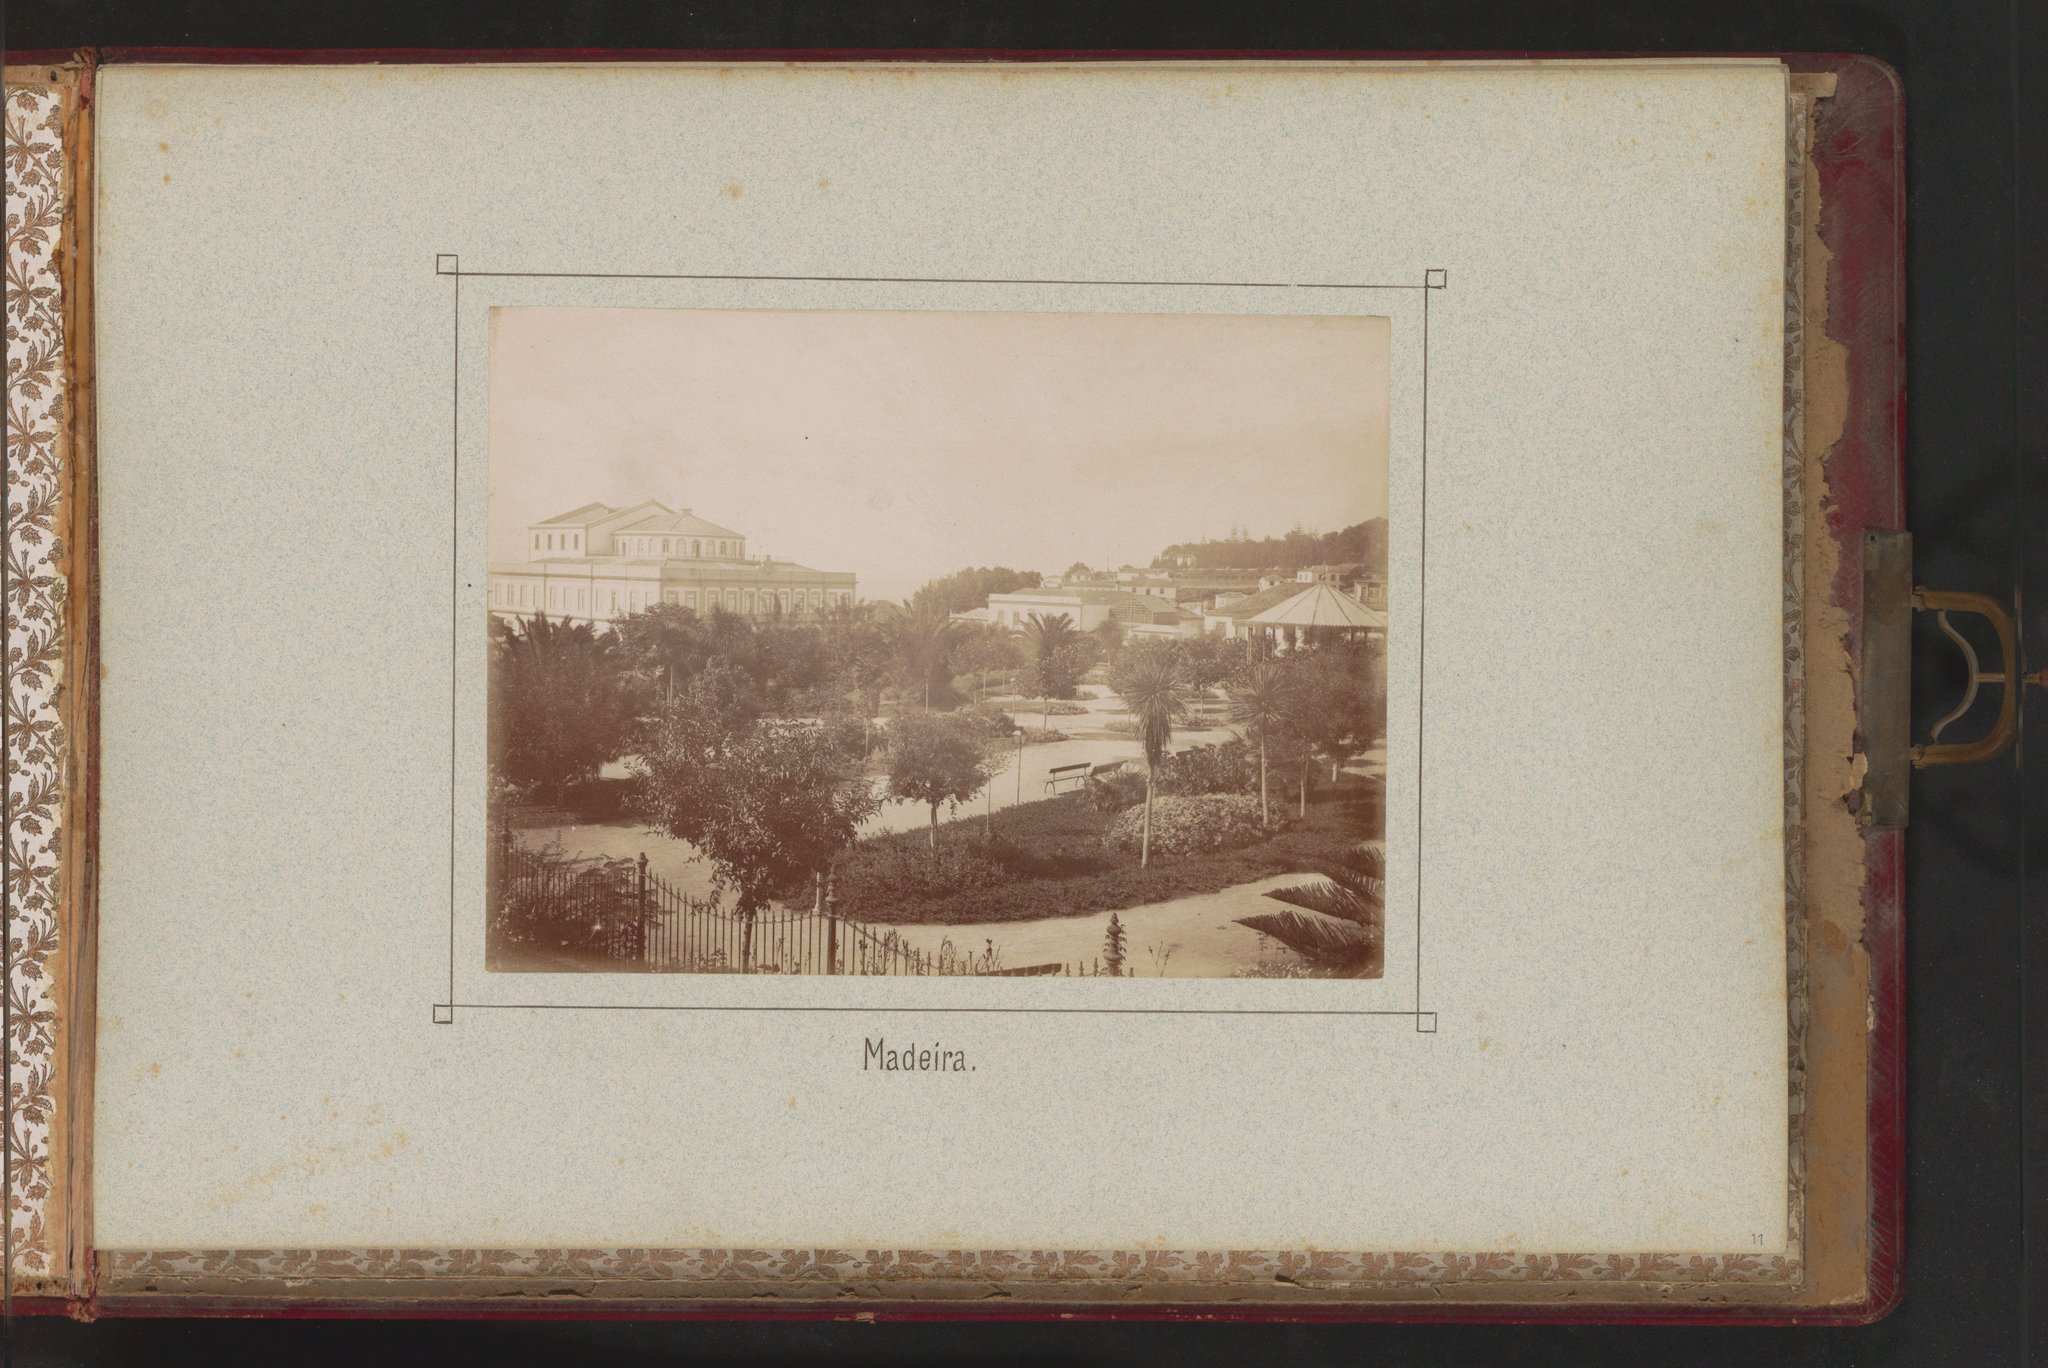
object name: photograph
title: Gebouw en park op Madeira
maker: Anonymous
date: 1880-1900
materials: photographic support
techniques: albumen print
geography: madeira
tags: public gardens, park (+ city(-scape) with figures, staffage)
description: Onderdeel van Reisalbum met foto's van Zuid-Afrika, Madeira, Portugal, Frankrijk en Duitsland.